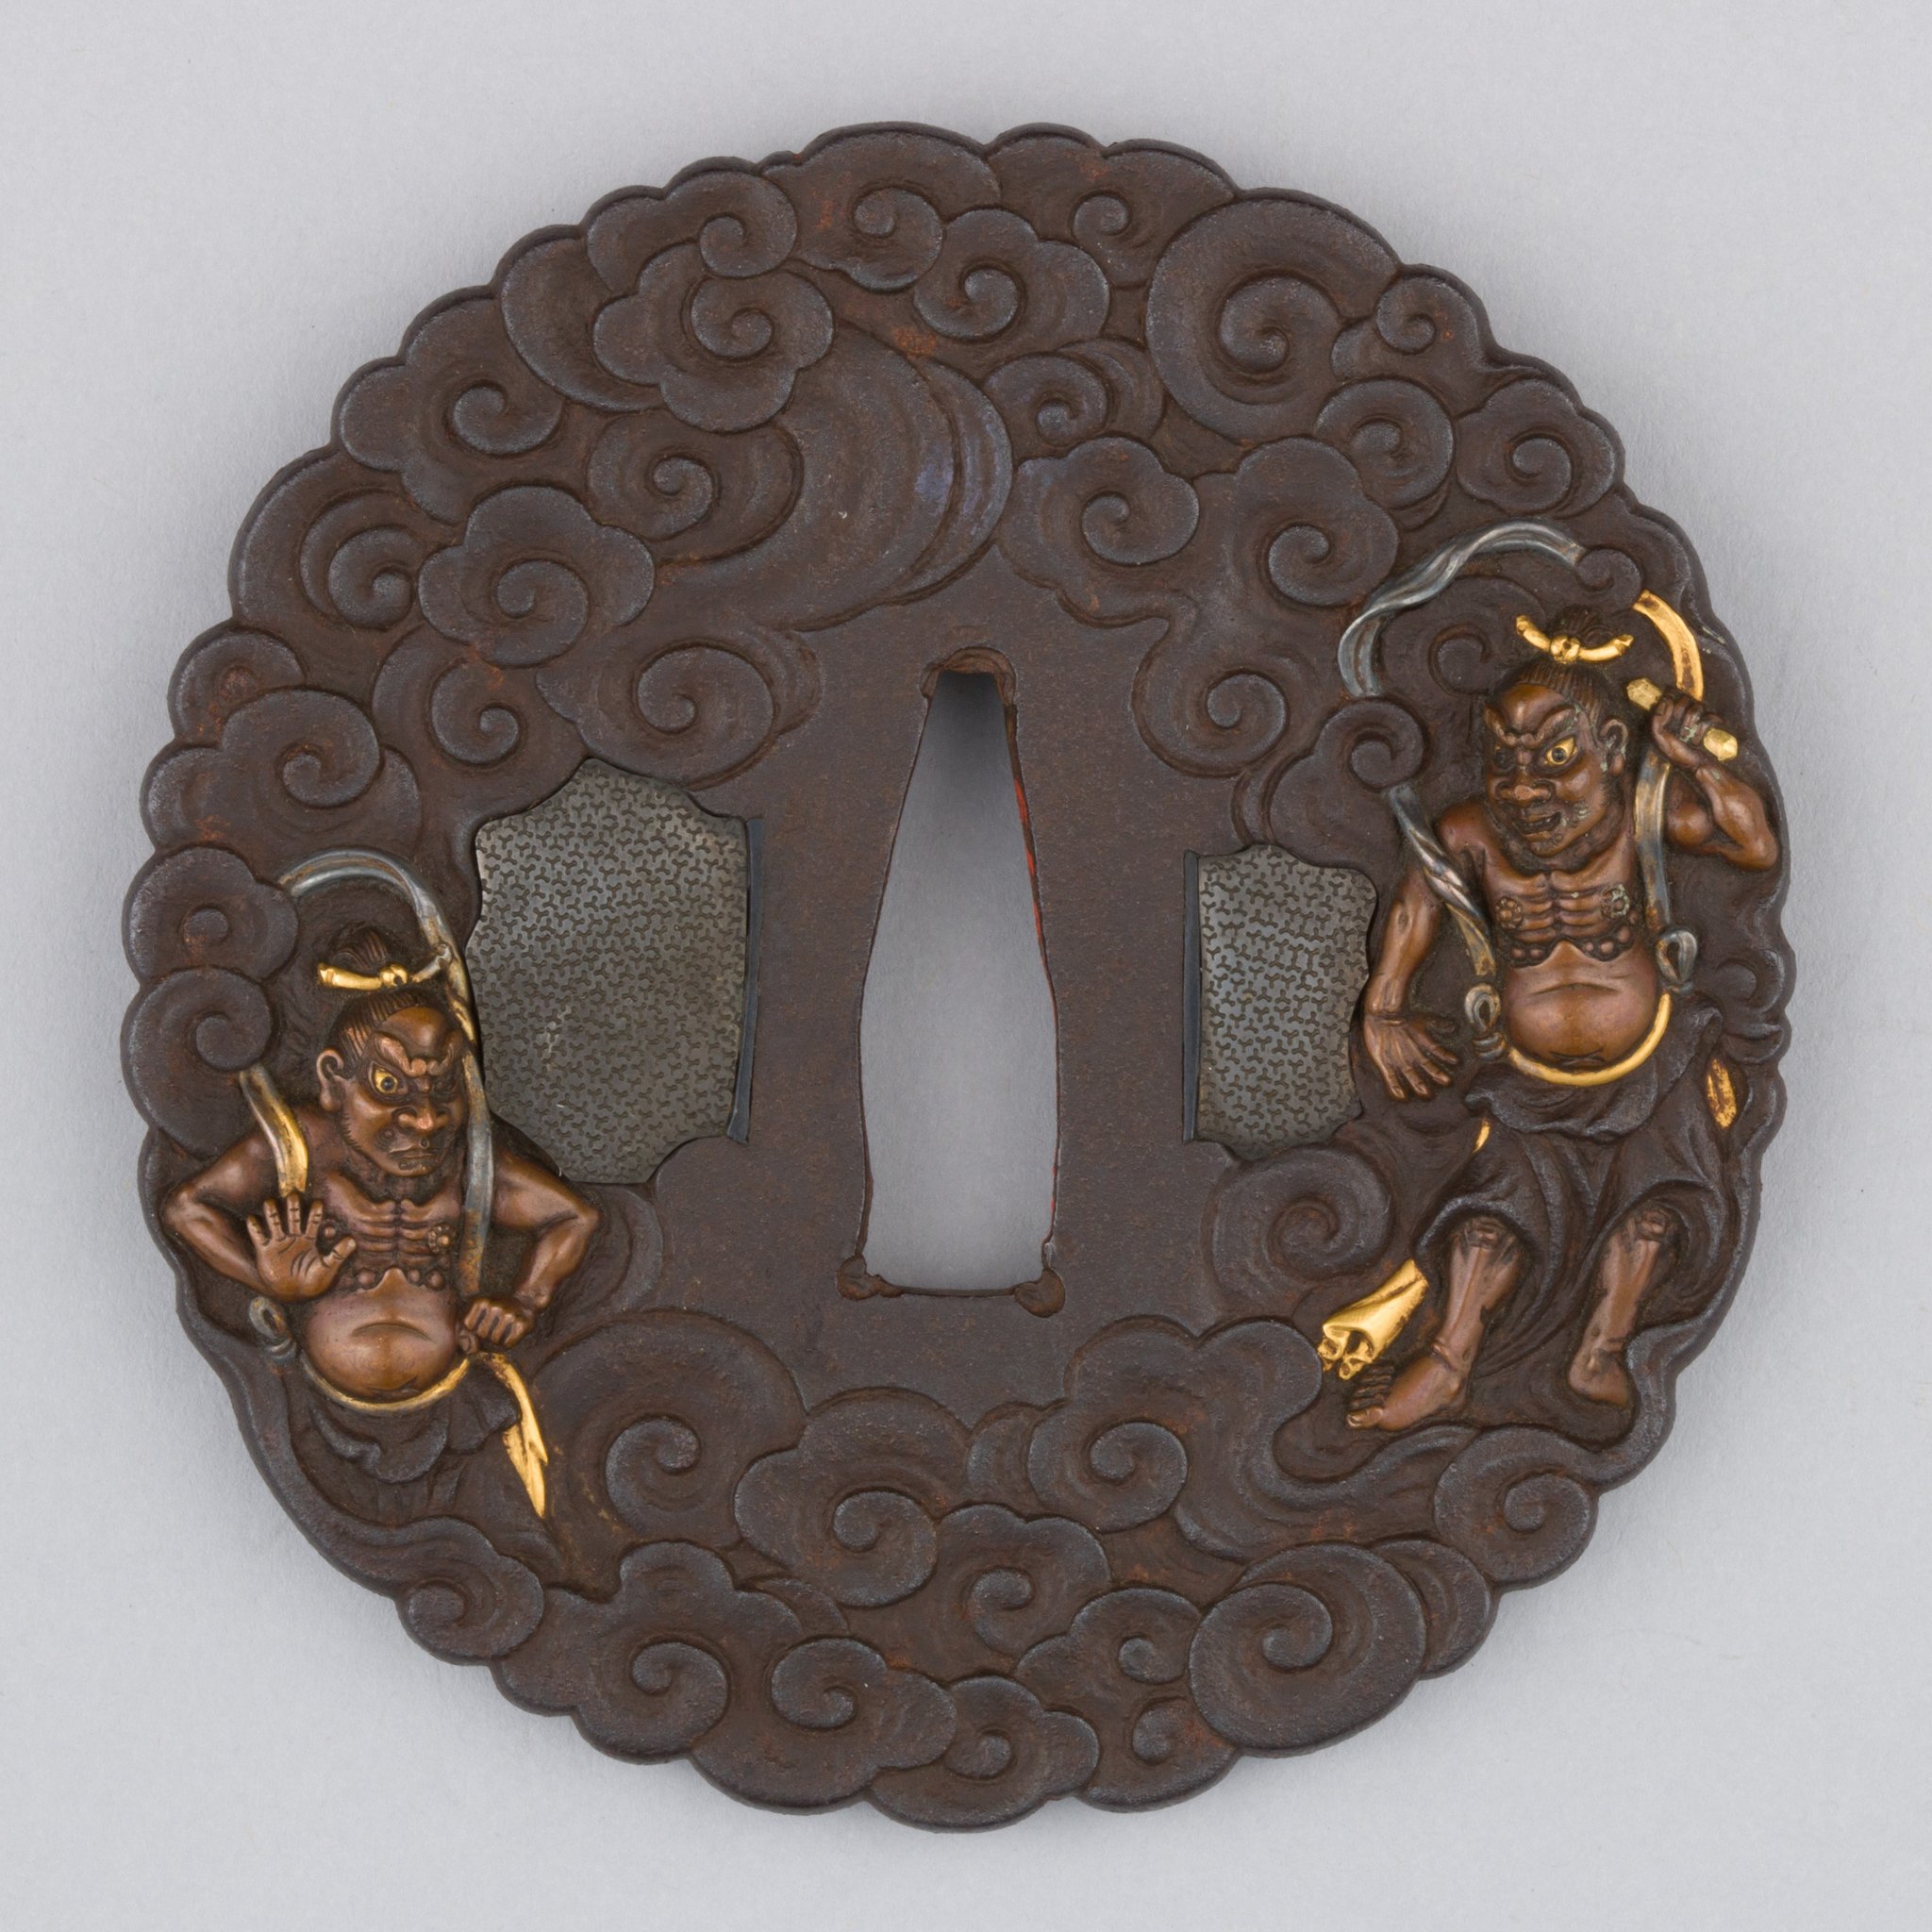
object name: sword guard tsuba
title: Sword Guard (Tsuba)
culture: japanese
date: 1615-1868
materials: copper, gold, iron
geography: japan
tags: men